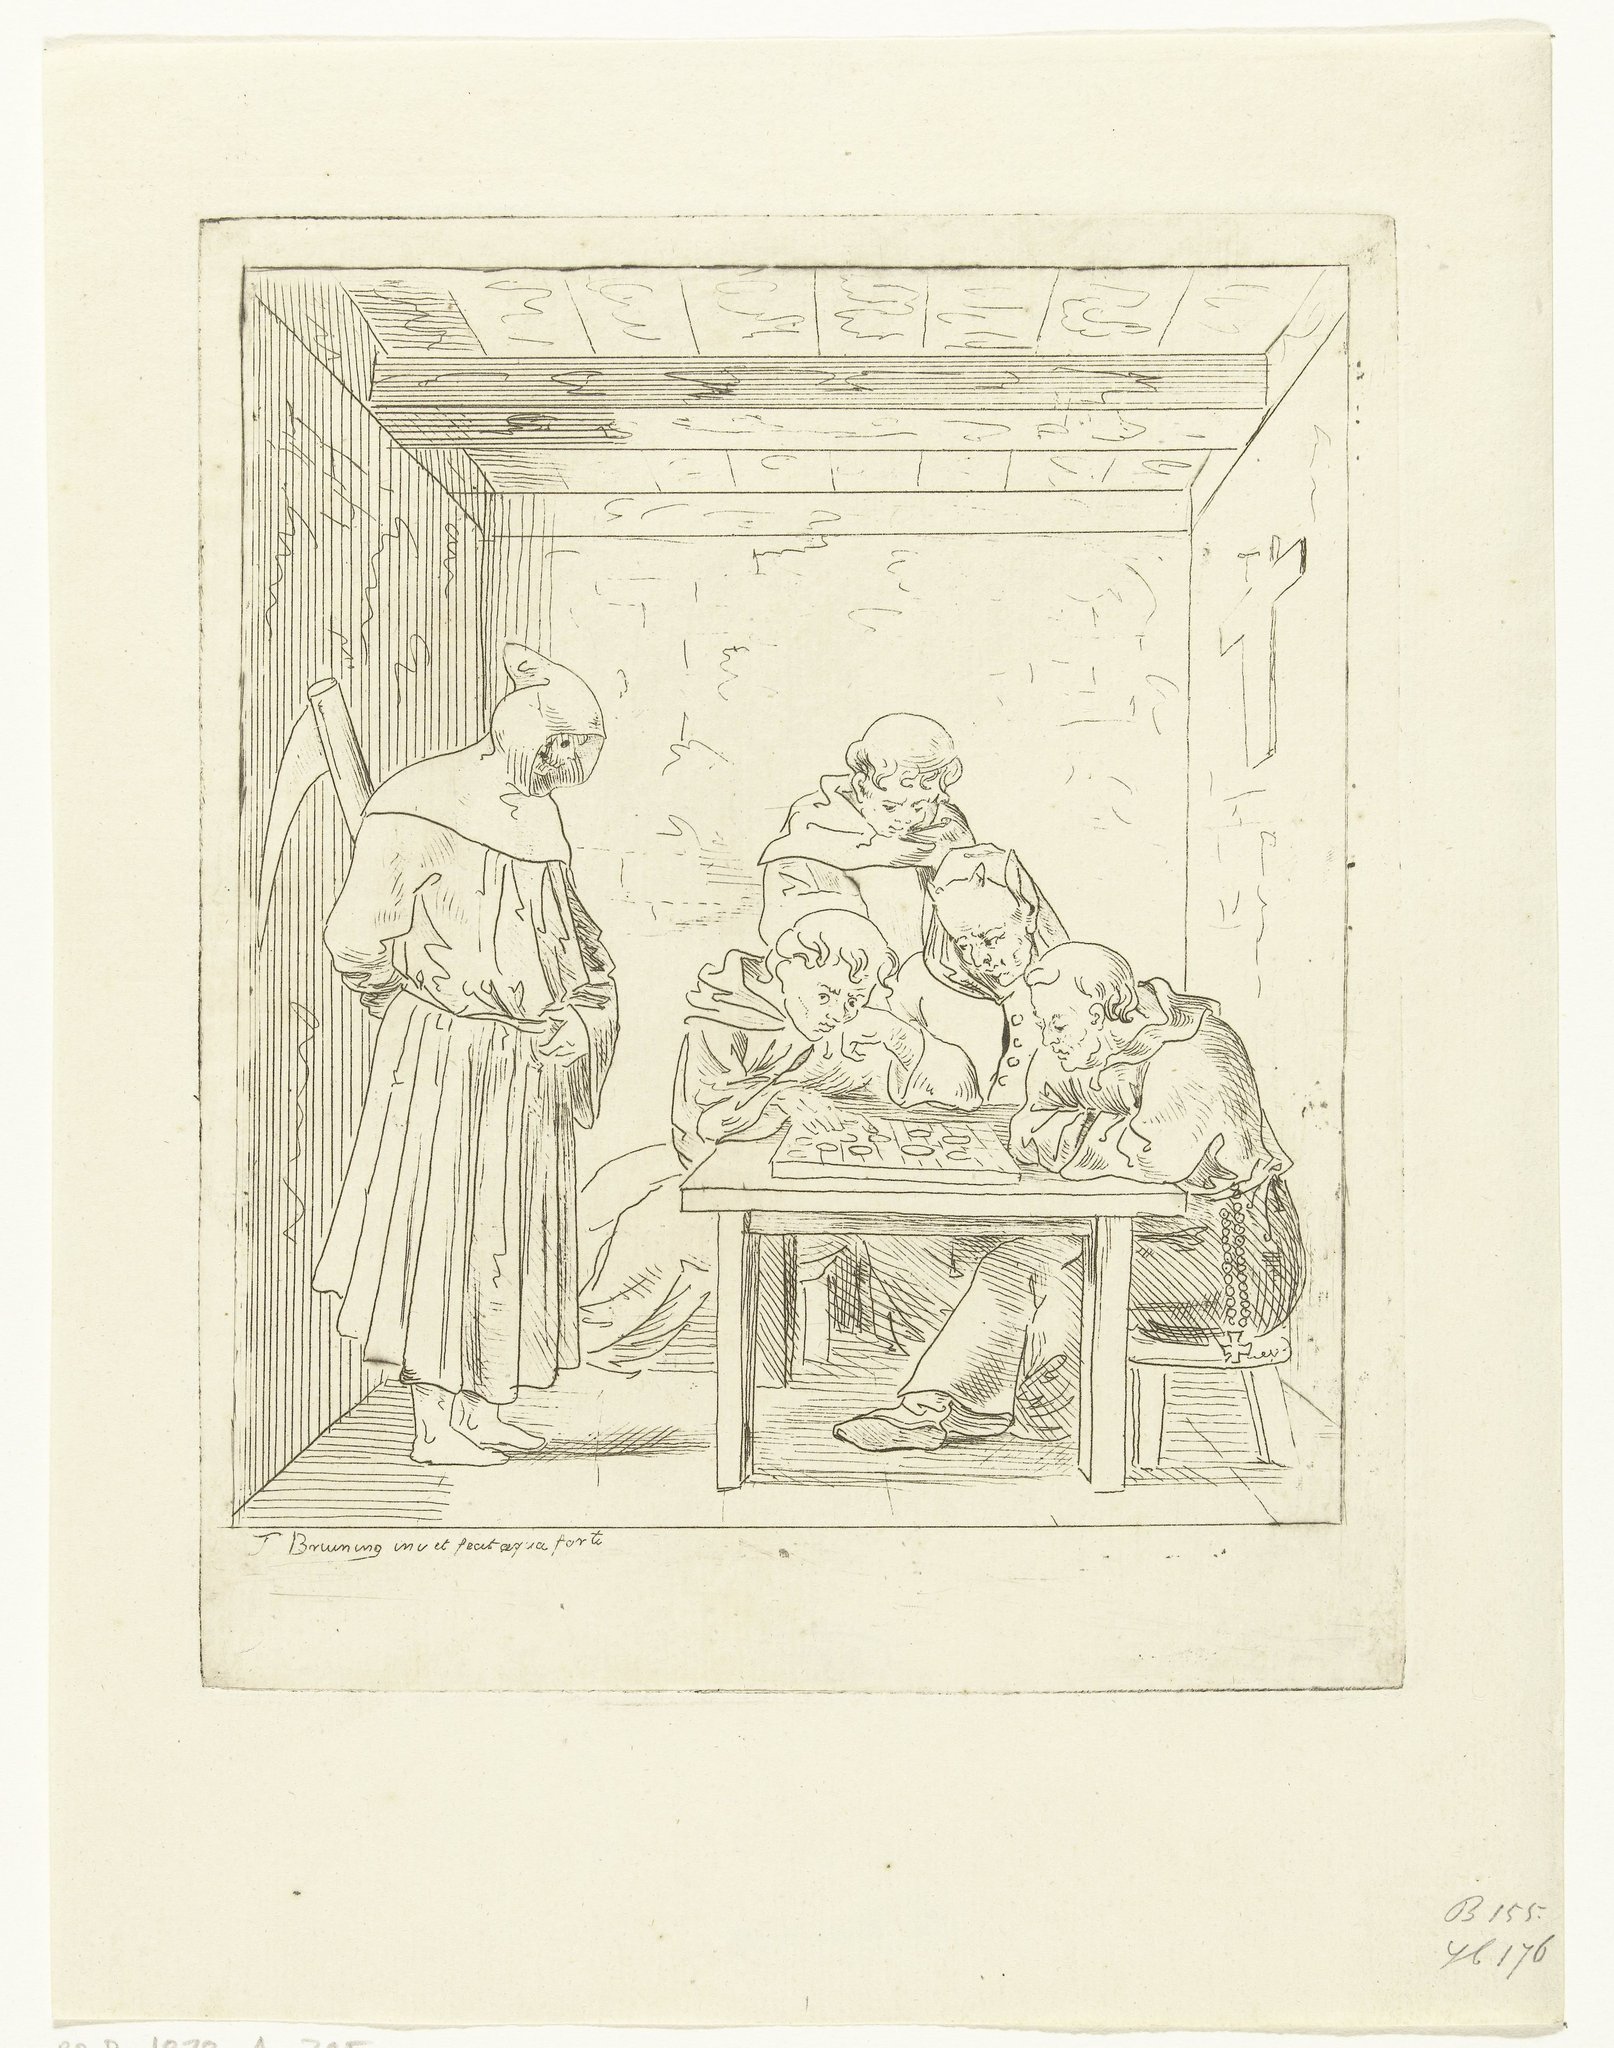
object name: print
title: Monniken bij het dammen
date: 1750-1850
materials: paper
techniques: etching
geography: netherlands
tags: draughts, monk(s), friar(s)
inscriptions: collector's mark: Lugt 2228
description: Twee monniken zitten aan een tafel te dammen. Achter hen staat een derde monnik en een duivel met een monnikspij aan. Naast de tafel staat de dood, eveneens vermomt als monnik. Hij draagt de zeis achter zijn rug. De monniken zijn zo verdiept in het spel dat ze de insluipers niet opmerken.